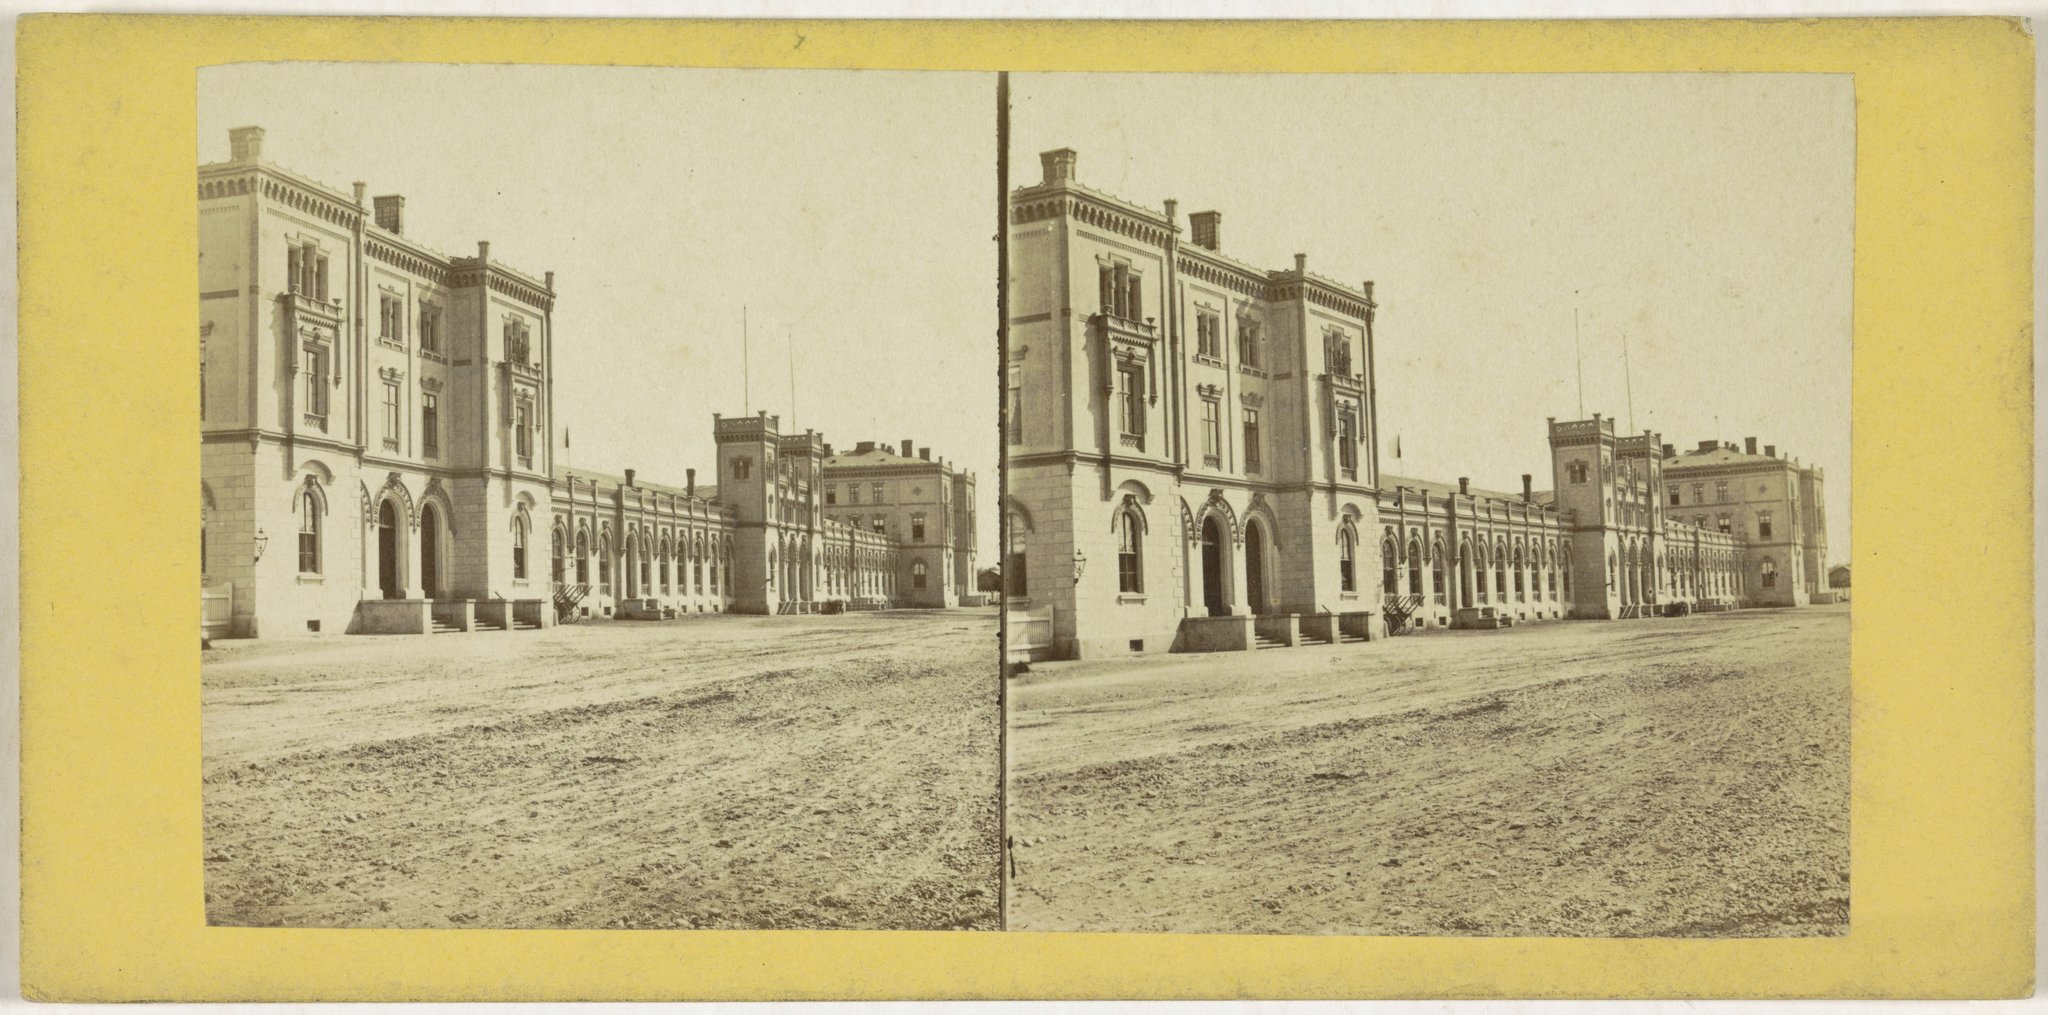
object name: stereograph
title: Danube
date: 1861-1870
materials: cardboard, paper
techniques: albumen print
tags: station; shelter (railway, tramway)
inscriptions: number: ‘372’